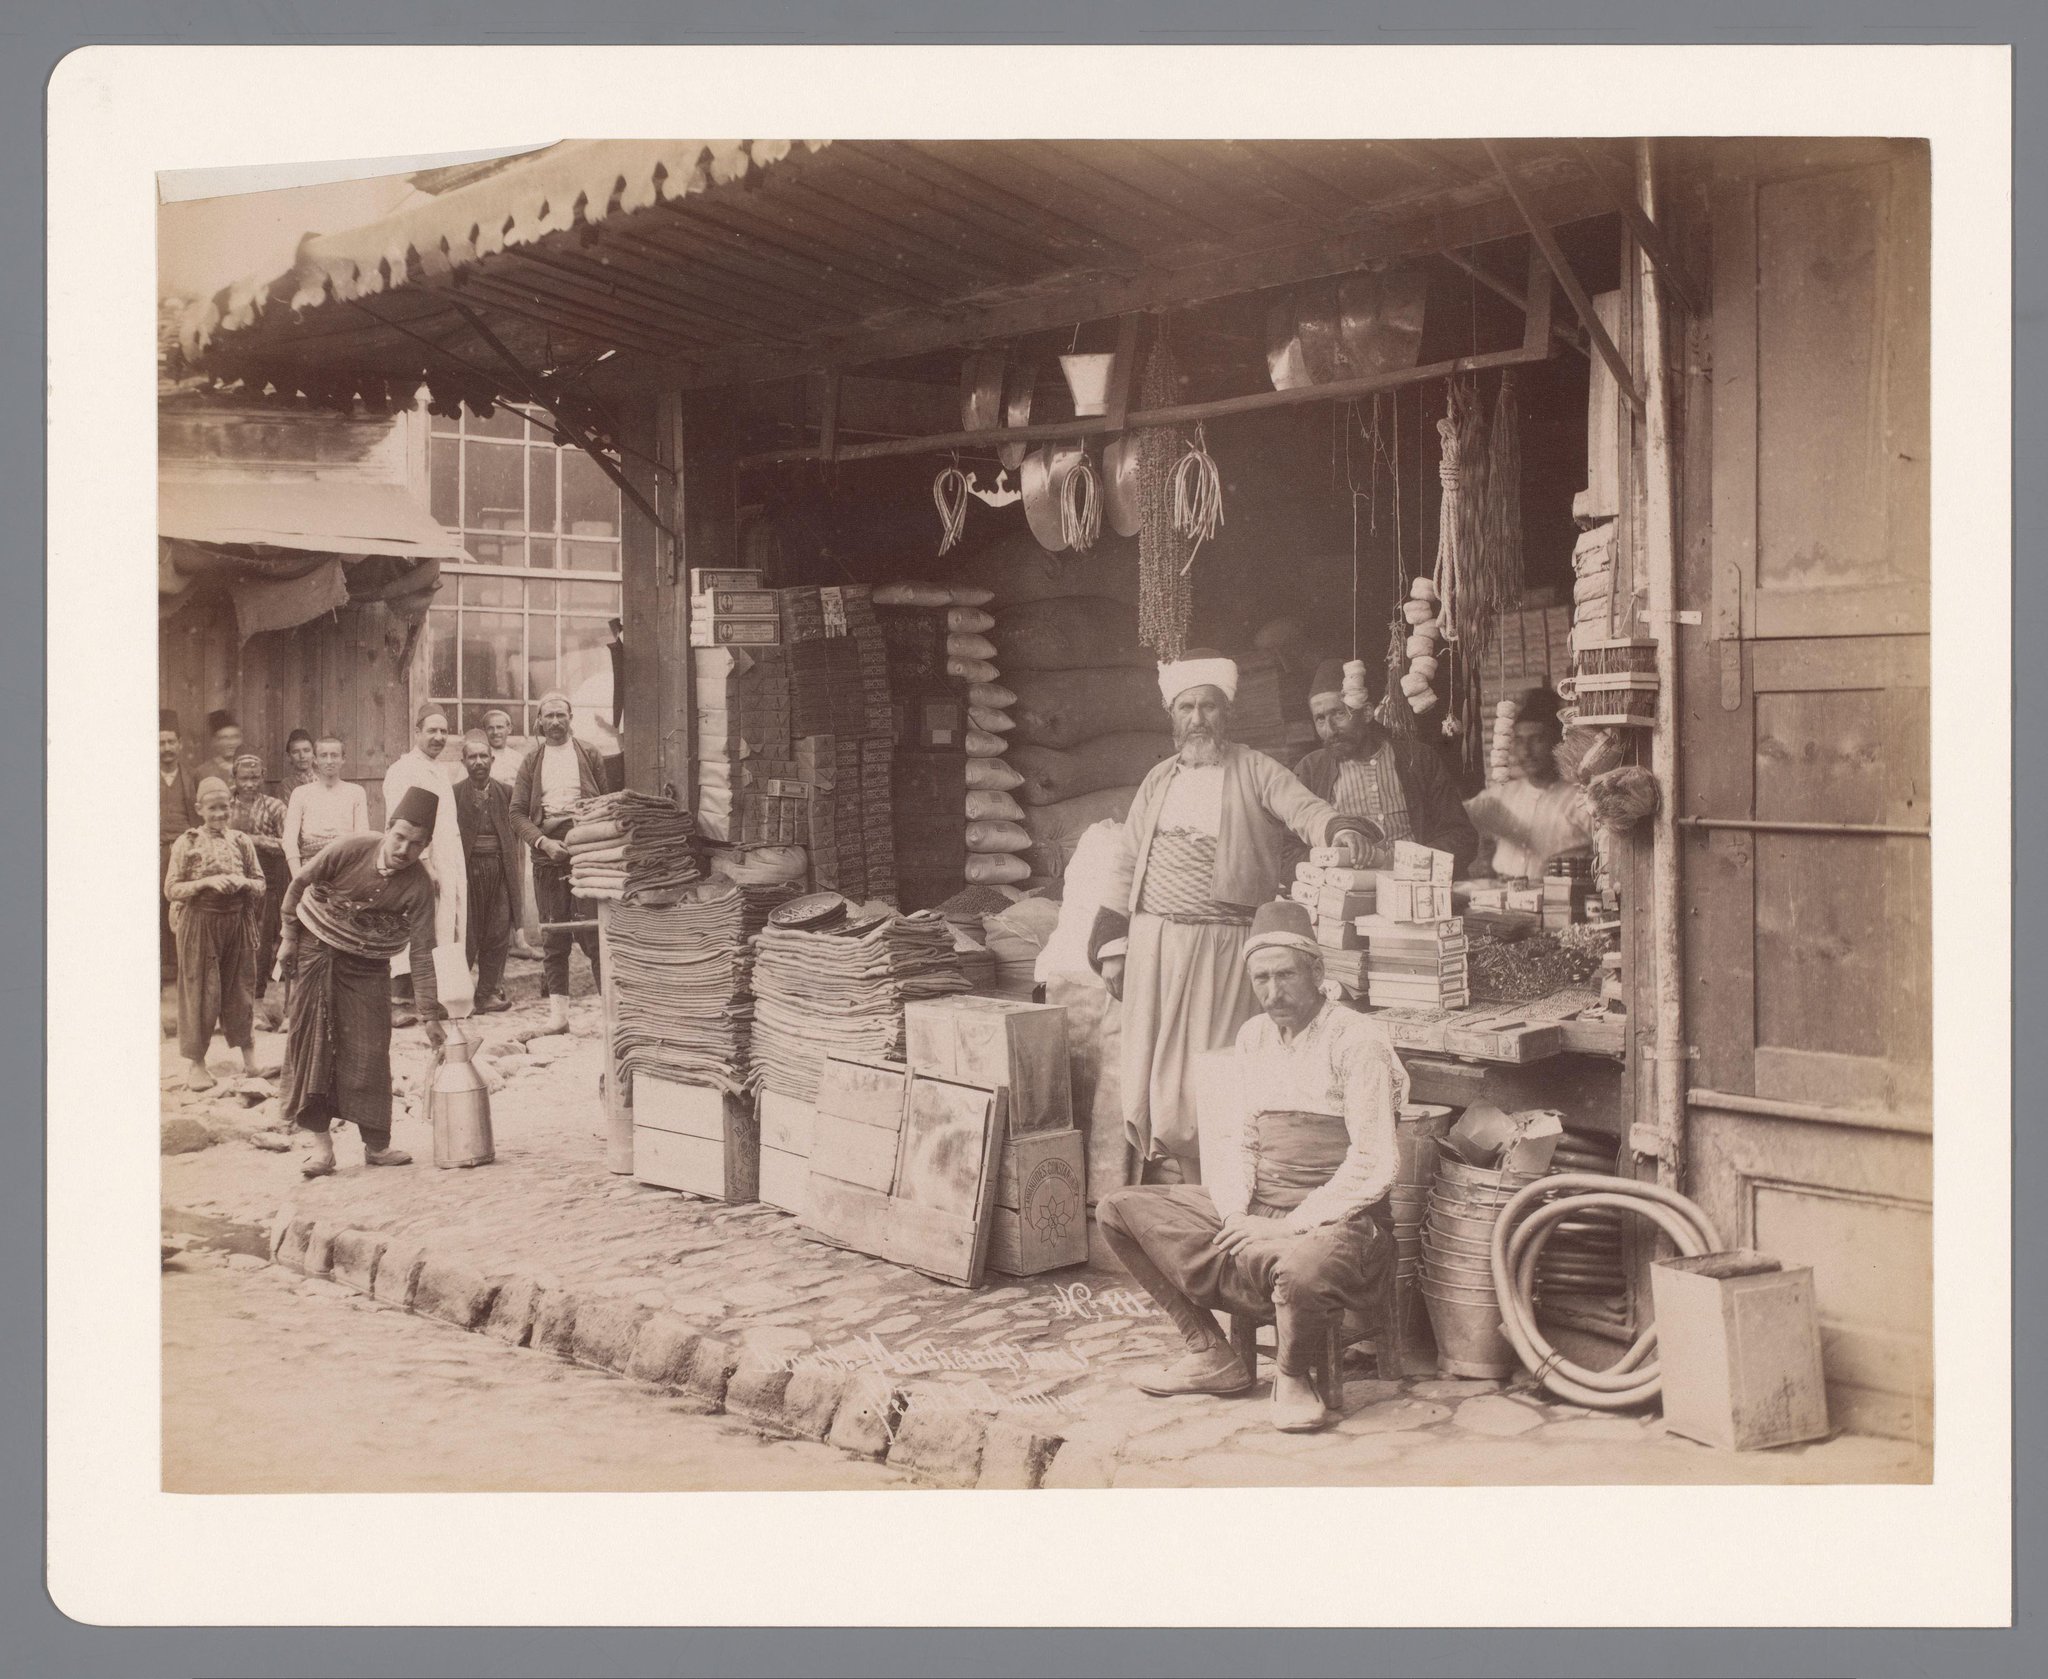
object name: photograph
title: Gezicht op een Koerdische winkel in Bursa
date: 1888-1900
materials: paper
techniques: albumen print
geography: bursa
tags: shop, store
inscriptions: number: ‘No, 111.’